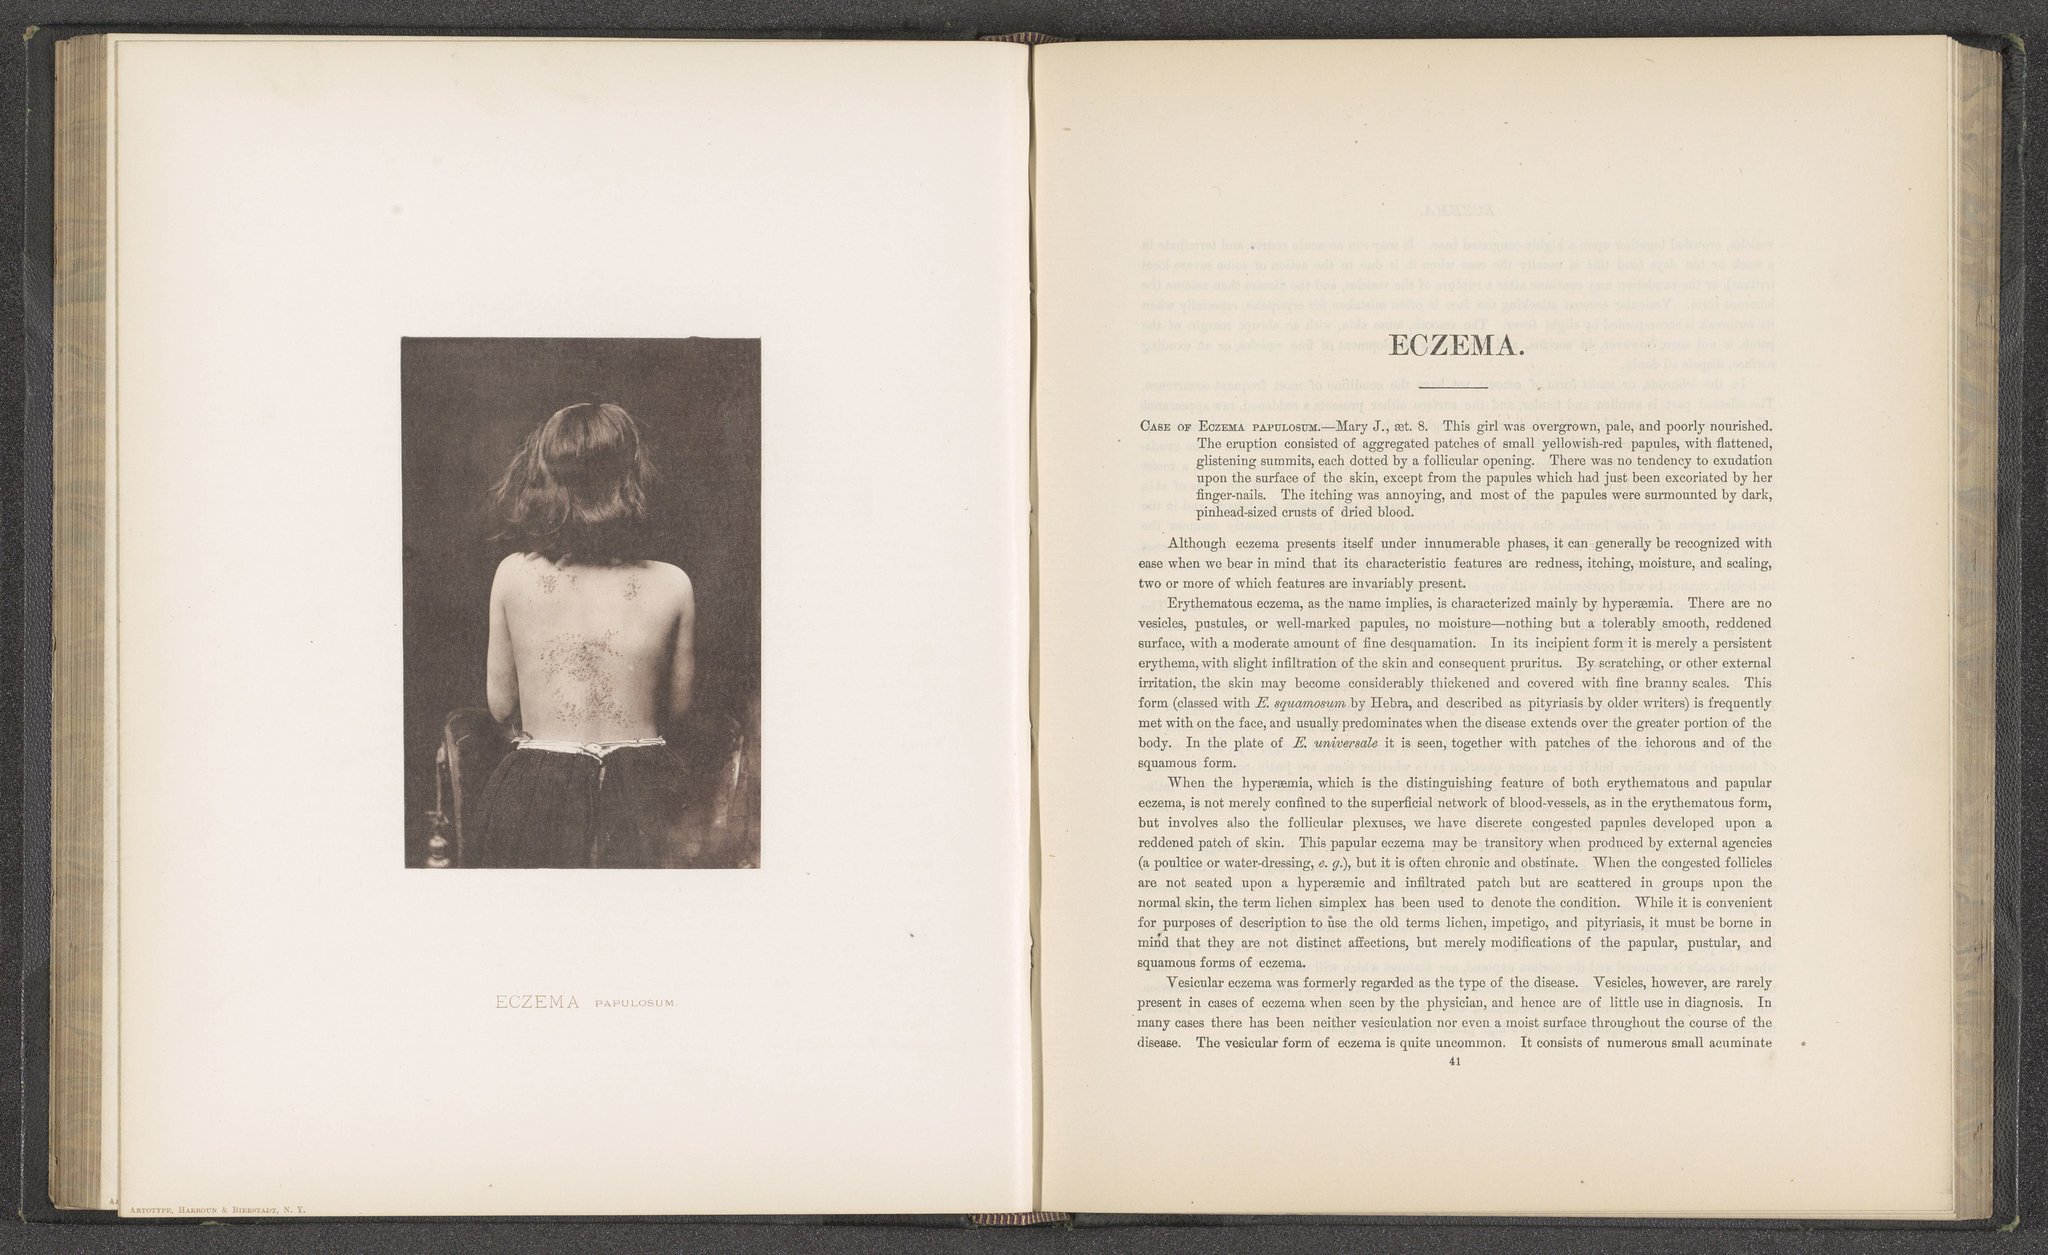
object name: page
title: Eczema papulosum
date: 1870-1881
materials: paper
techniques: photograph, hand coloring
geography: new york city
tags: adolescent, young woman, maiden, skin and venereal diseases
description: Prent tegenover pagina 41. In het boek zijn de pagina's 39 tot en met 46 dubbel opgenomen, evenals de bijbehorende prenten. Onderhavige prent staat in de tweede set.